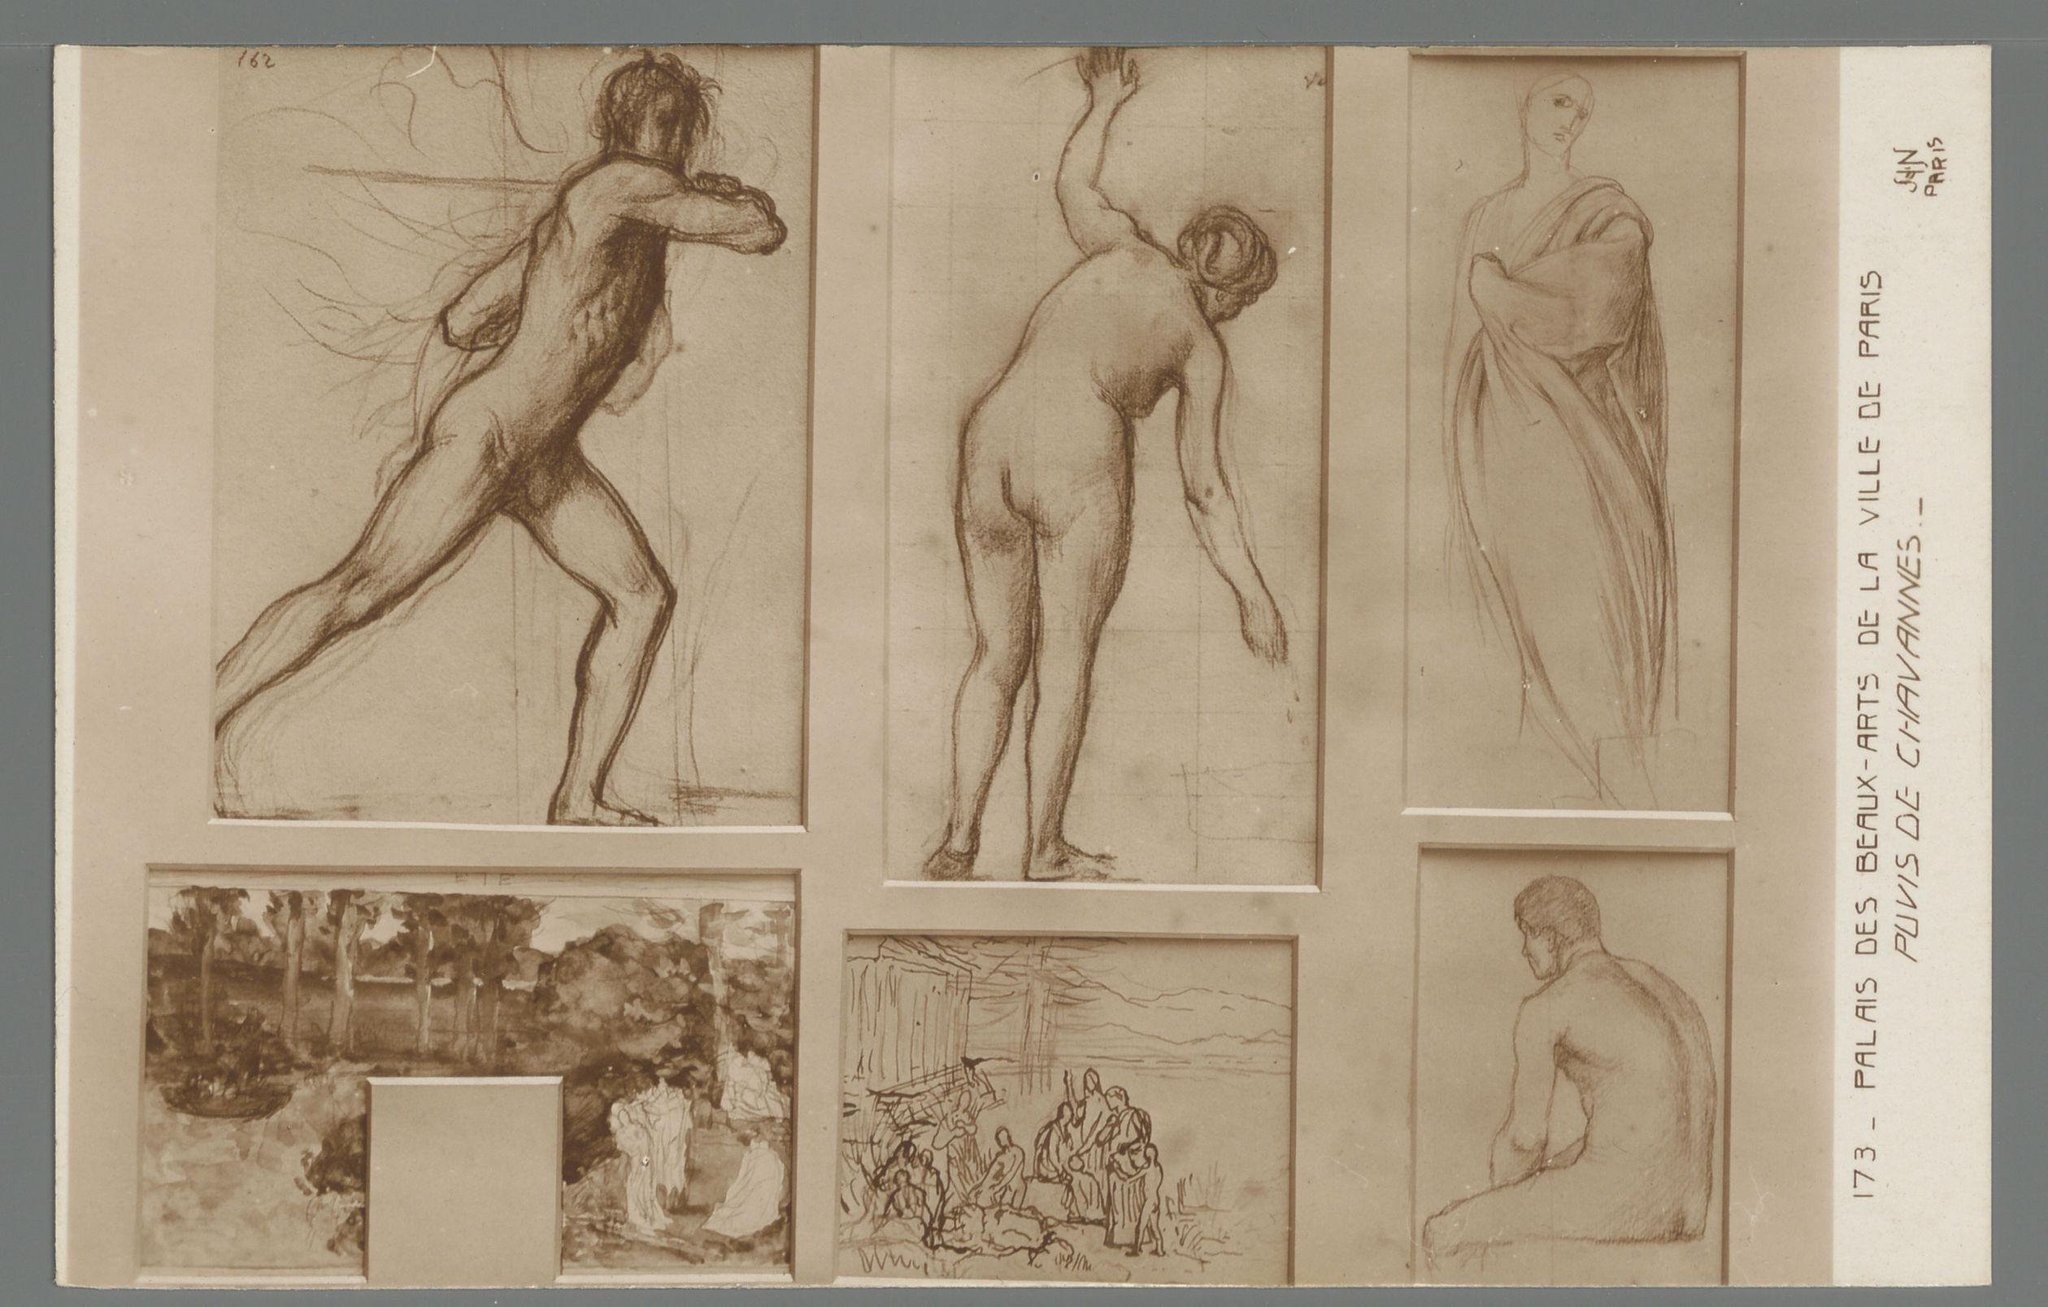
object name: reproduction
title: Palais des Beaux-Arts de la ville de Paris. Puvis de Chavannes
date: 1910-1930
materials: photographic support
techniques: photography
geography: paris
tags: drawing, sketch, permanent exhibition, museum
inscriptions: collector's mark: ‘AFE v S’